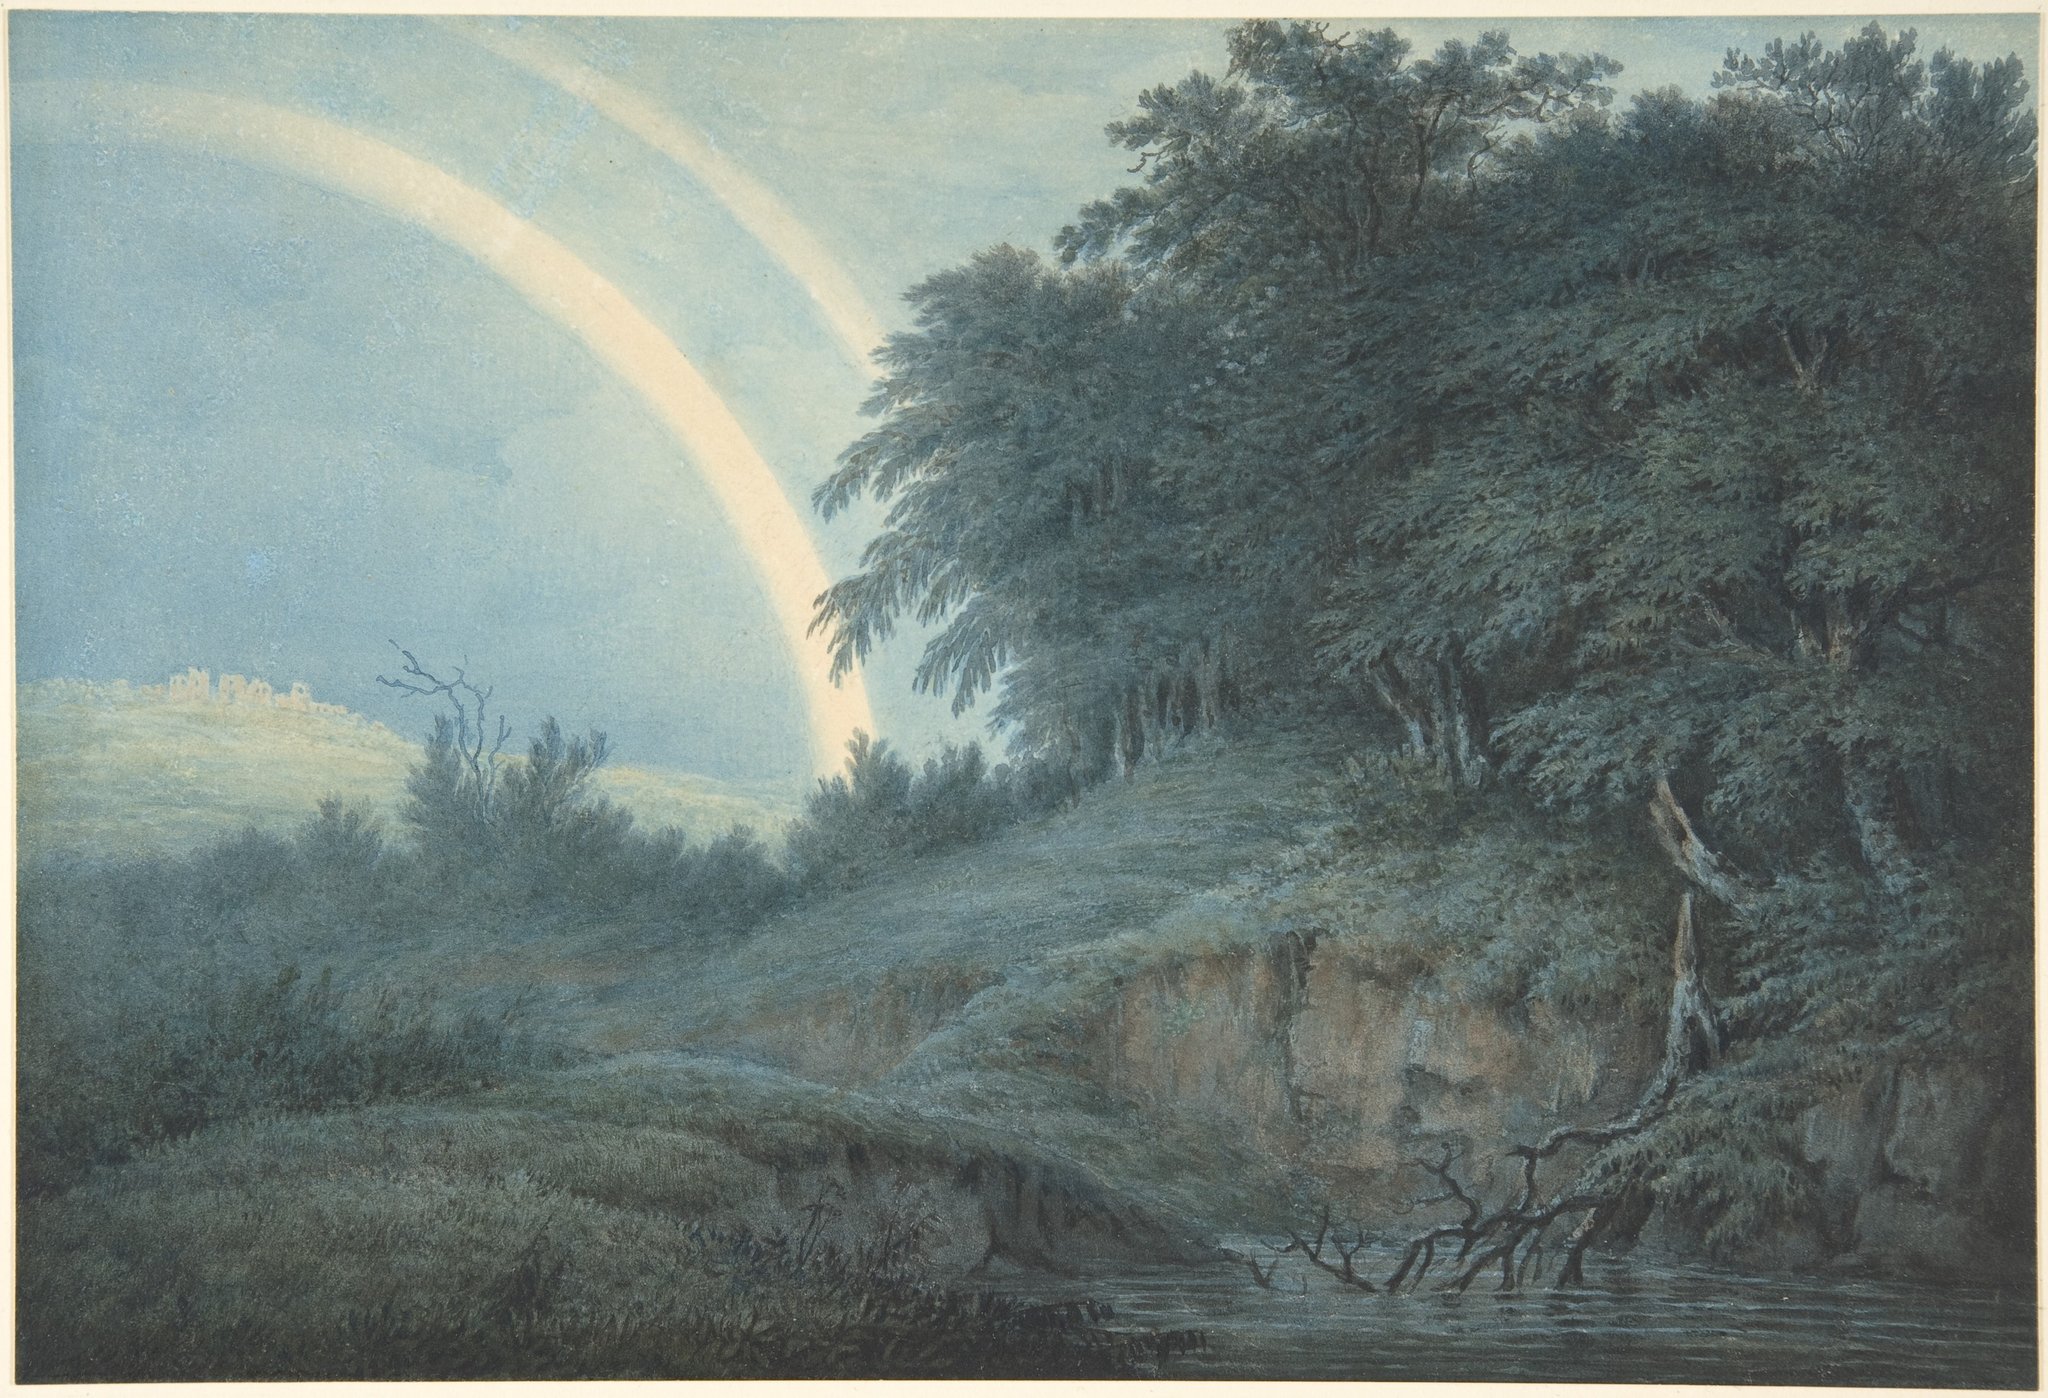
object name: drawing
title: The Rainbow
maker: john glover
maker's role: artist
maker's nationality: british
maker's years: 1767-1849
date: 1794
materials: graphite, watercolor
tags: trees,rainbows